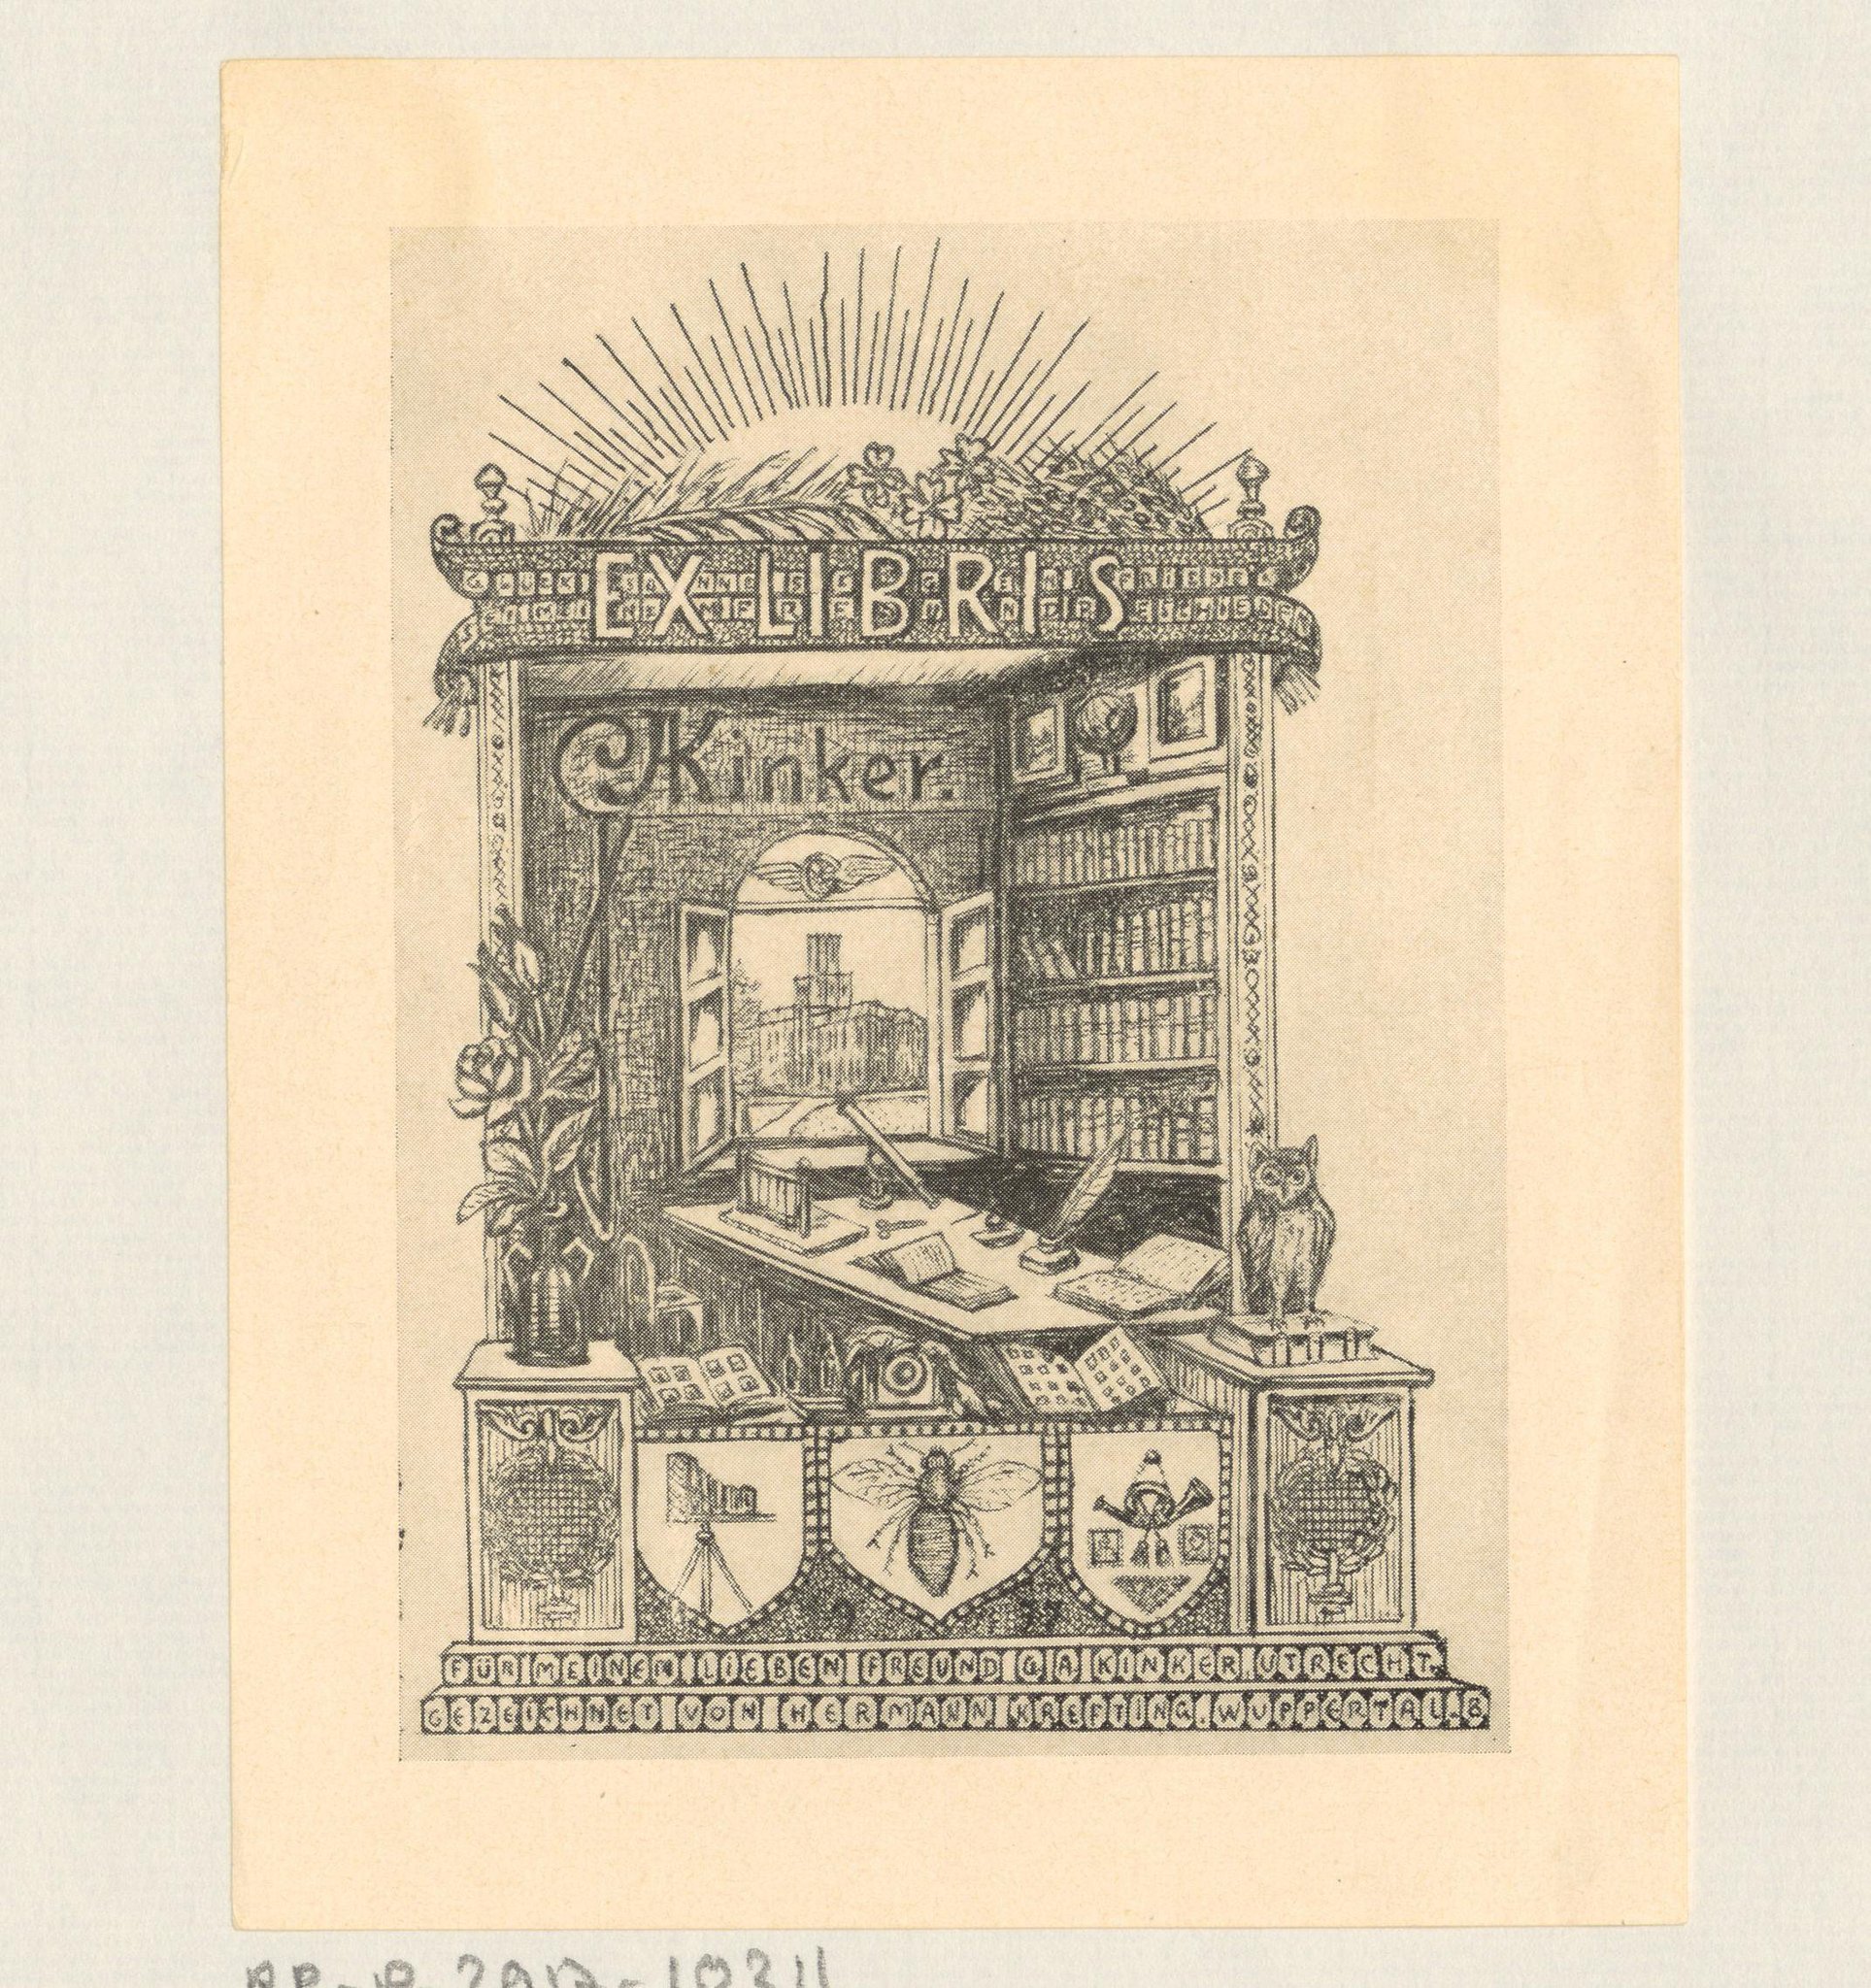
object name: photomechanical print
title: Ex libris van G.A. Kinker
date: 1937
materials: paper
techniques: autotype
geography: wuppertal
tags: g.a. kinker, bookshelves, view through a window, study; 'studiolo'; library, owls, insects: bee, flowers: rose